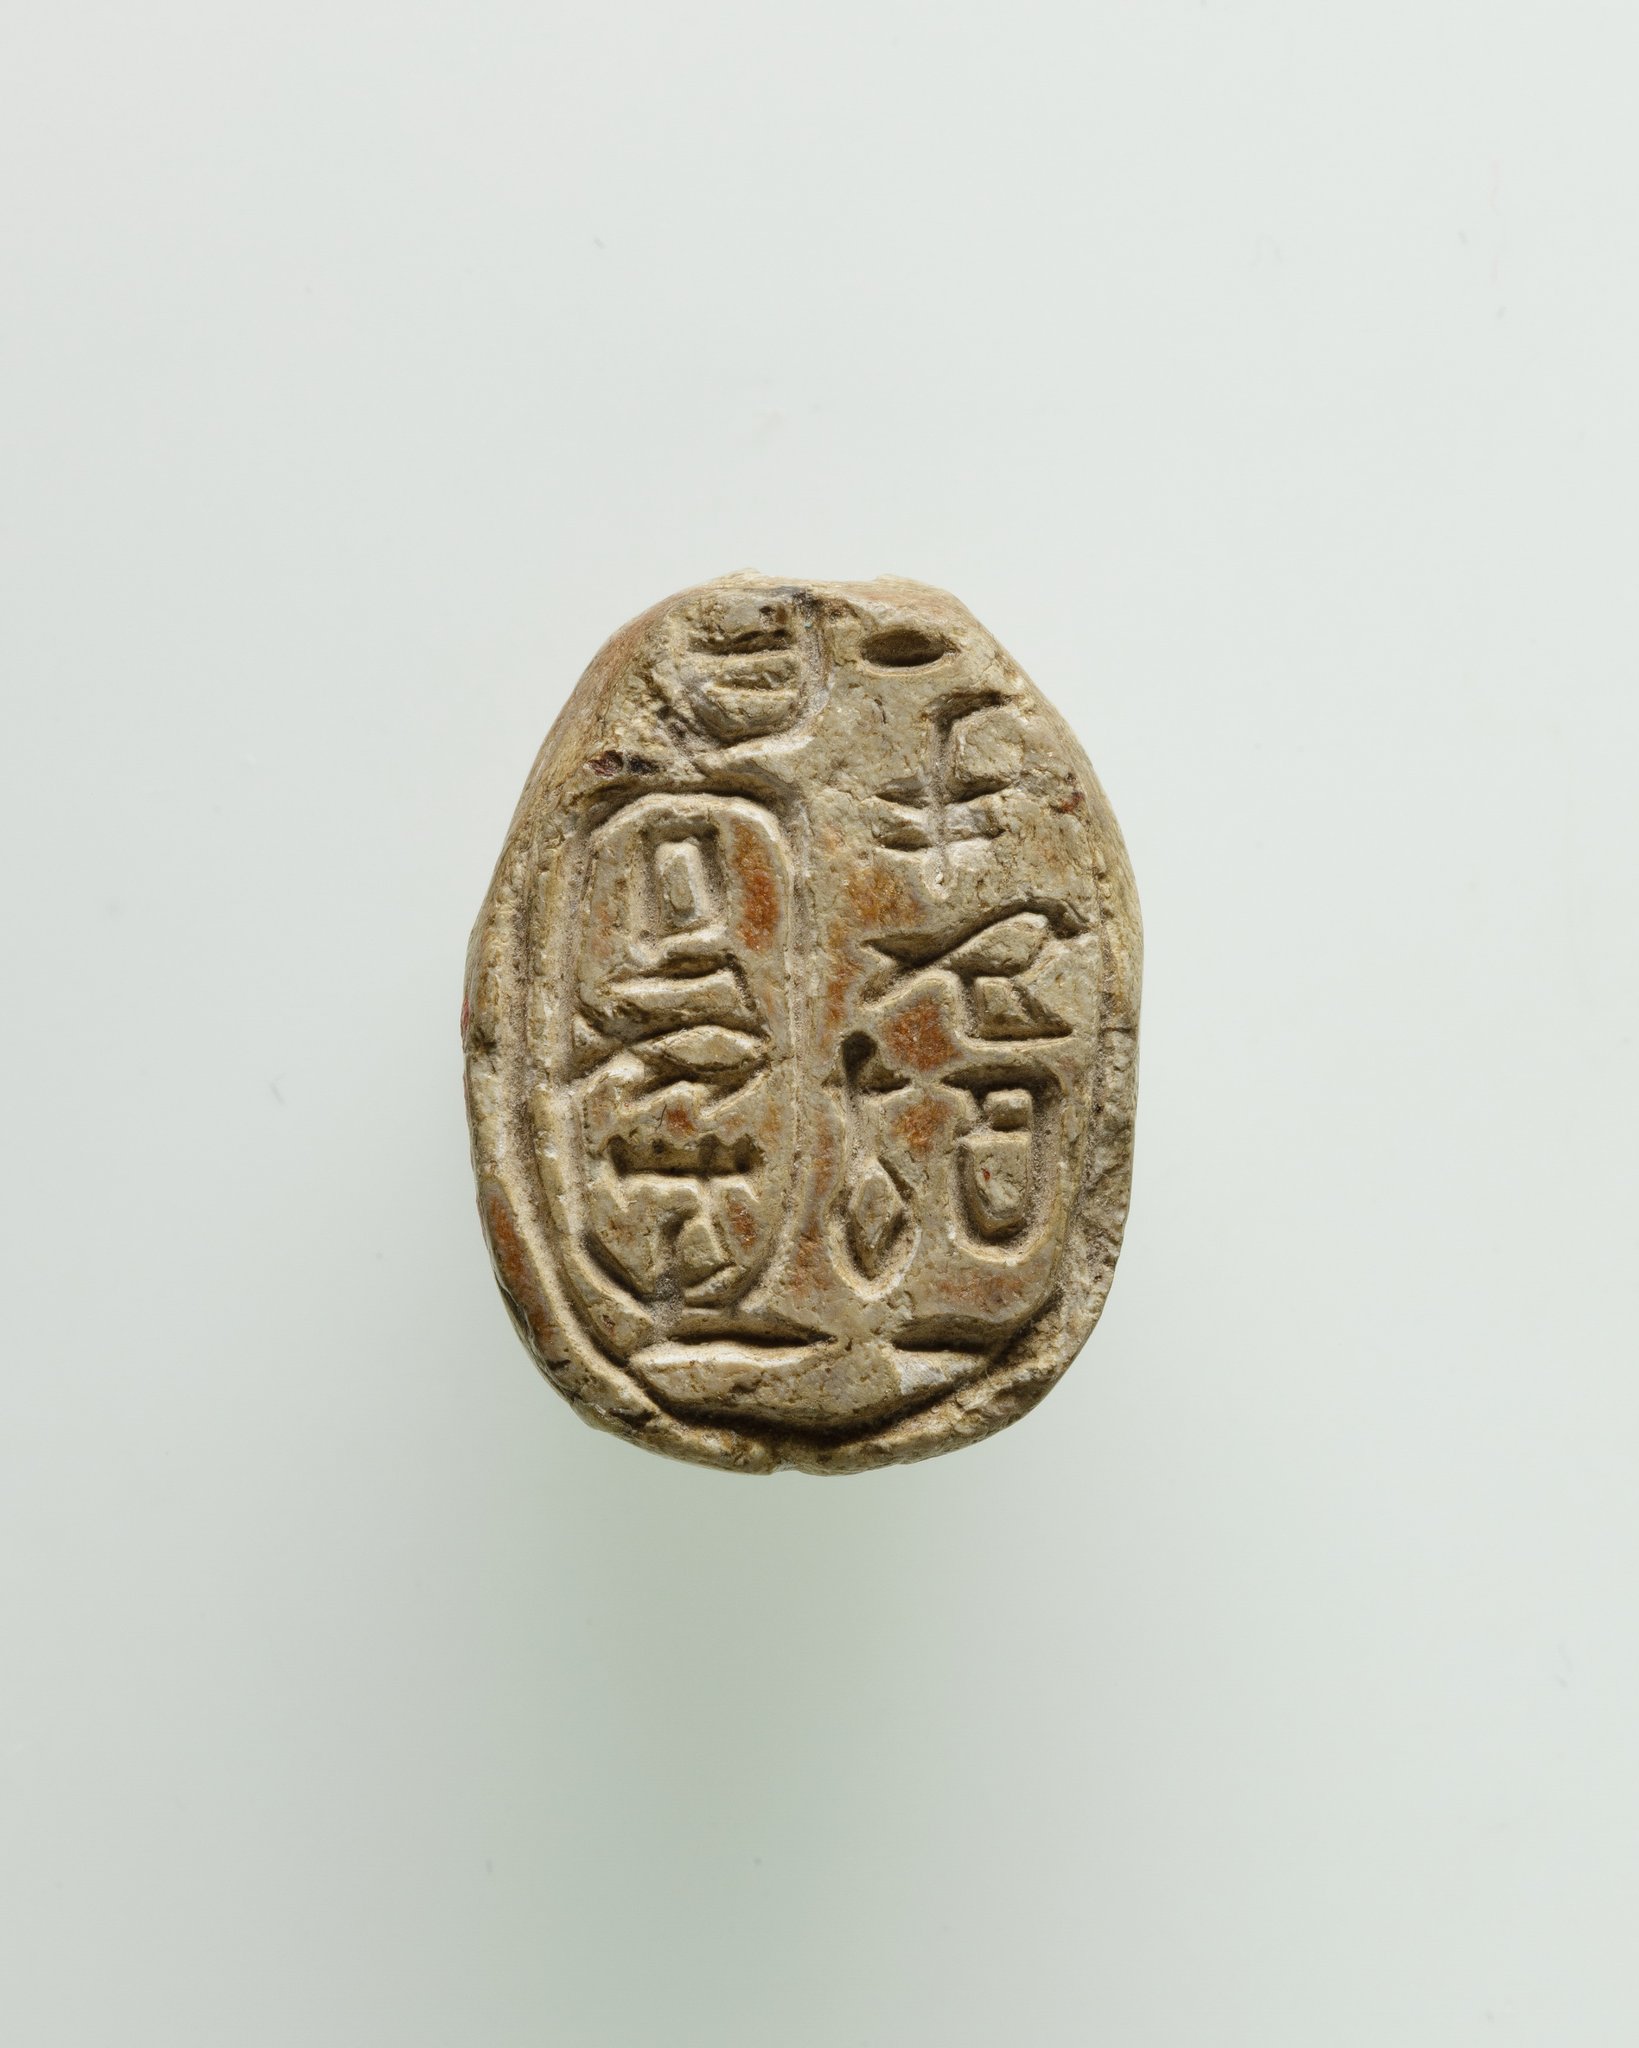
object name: scarab, ini, great royal wife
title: Scarab of the "Great Royal Wife" Ini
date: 1640-1550 BCE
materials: stone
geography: egypt